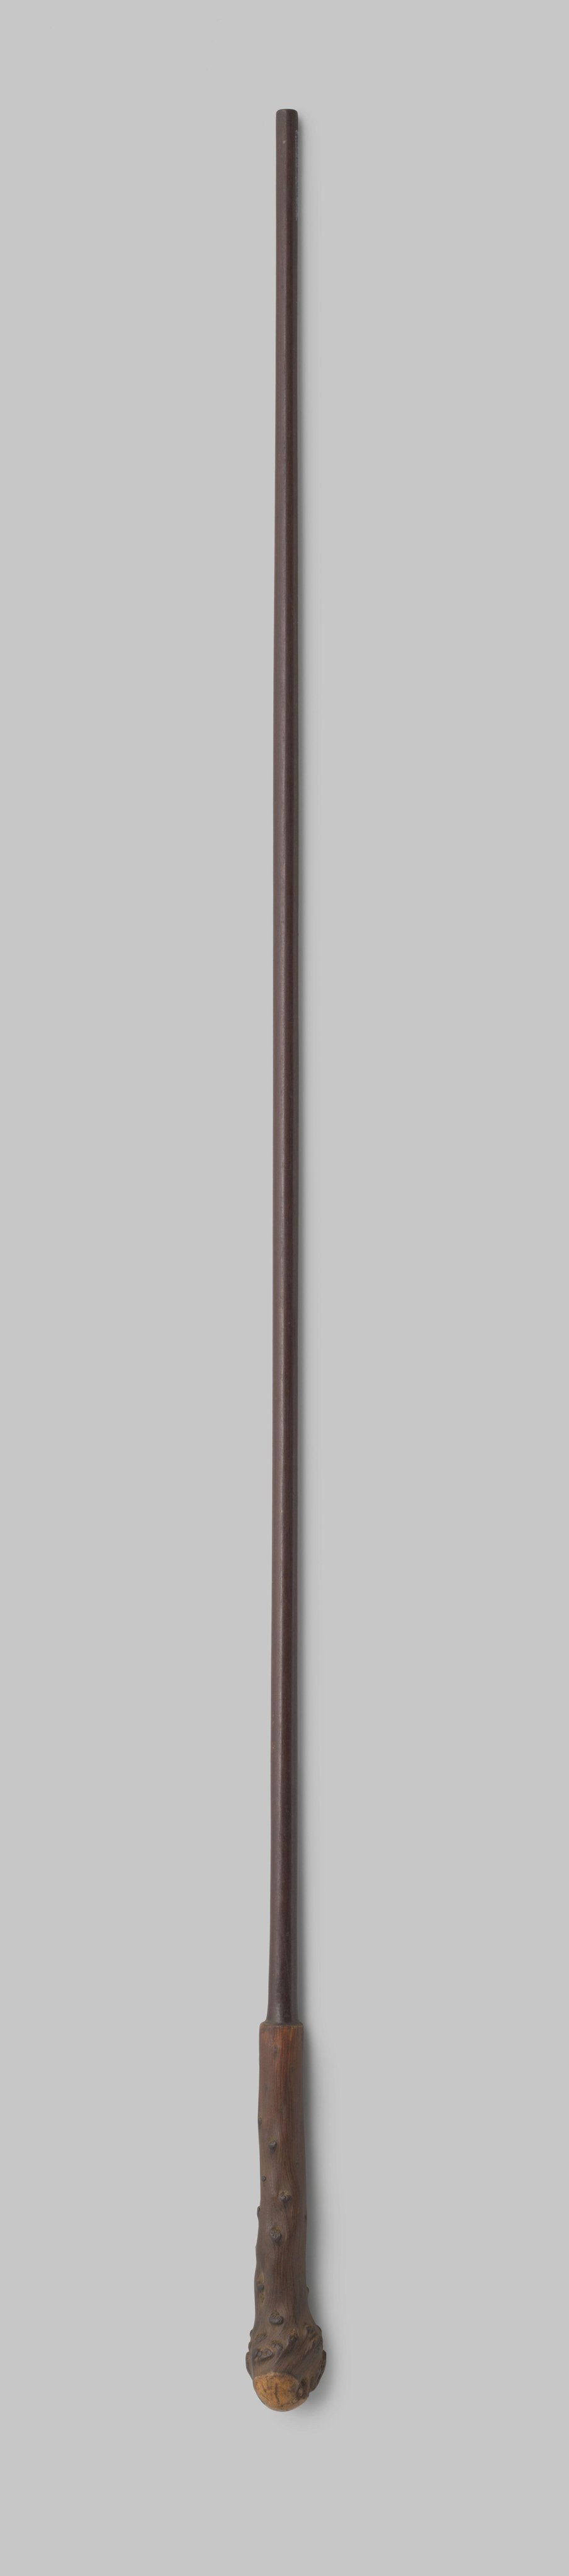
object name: onderstok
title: Onderstok van parapluie of parasol van een tropische houtsoort (amarant?) met knoestige knop van gekleurd, warrig hout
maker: gustav schnitzler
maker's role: paraplufabrikant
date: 1920-1940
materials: wood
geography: nijmegen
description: Onderstok van parapluie of parasol van een tropische houtsoort (amarant?) met knoestige knop van gekleurd, warrig hout.